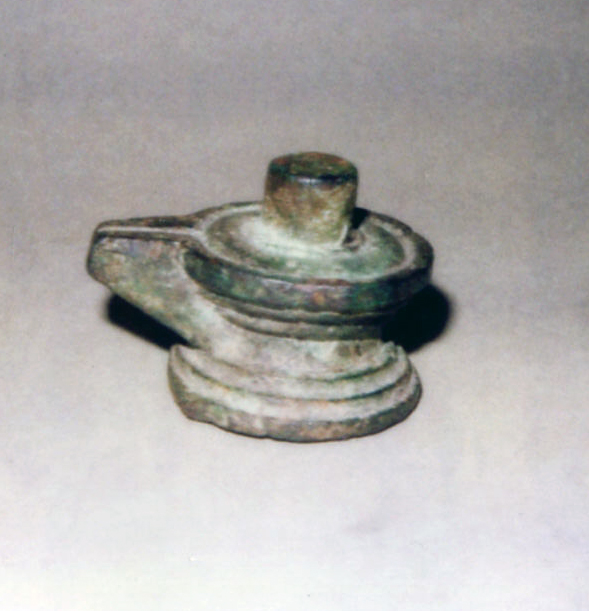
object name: linga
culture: nepali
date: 1001-1200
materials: bronze